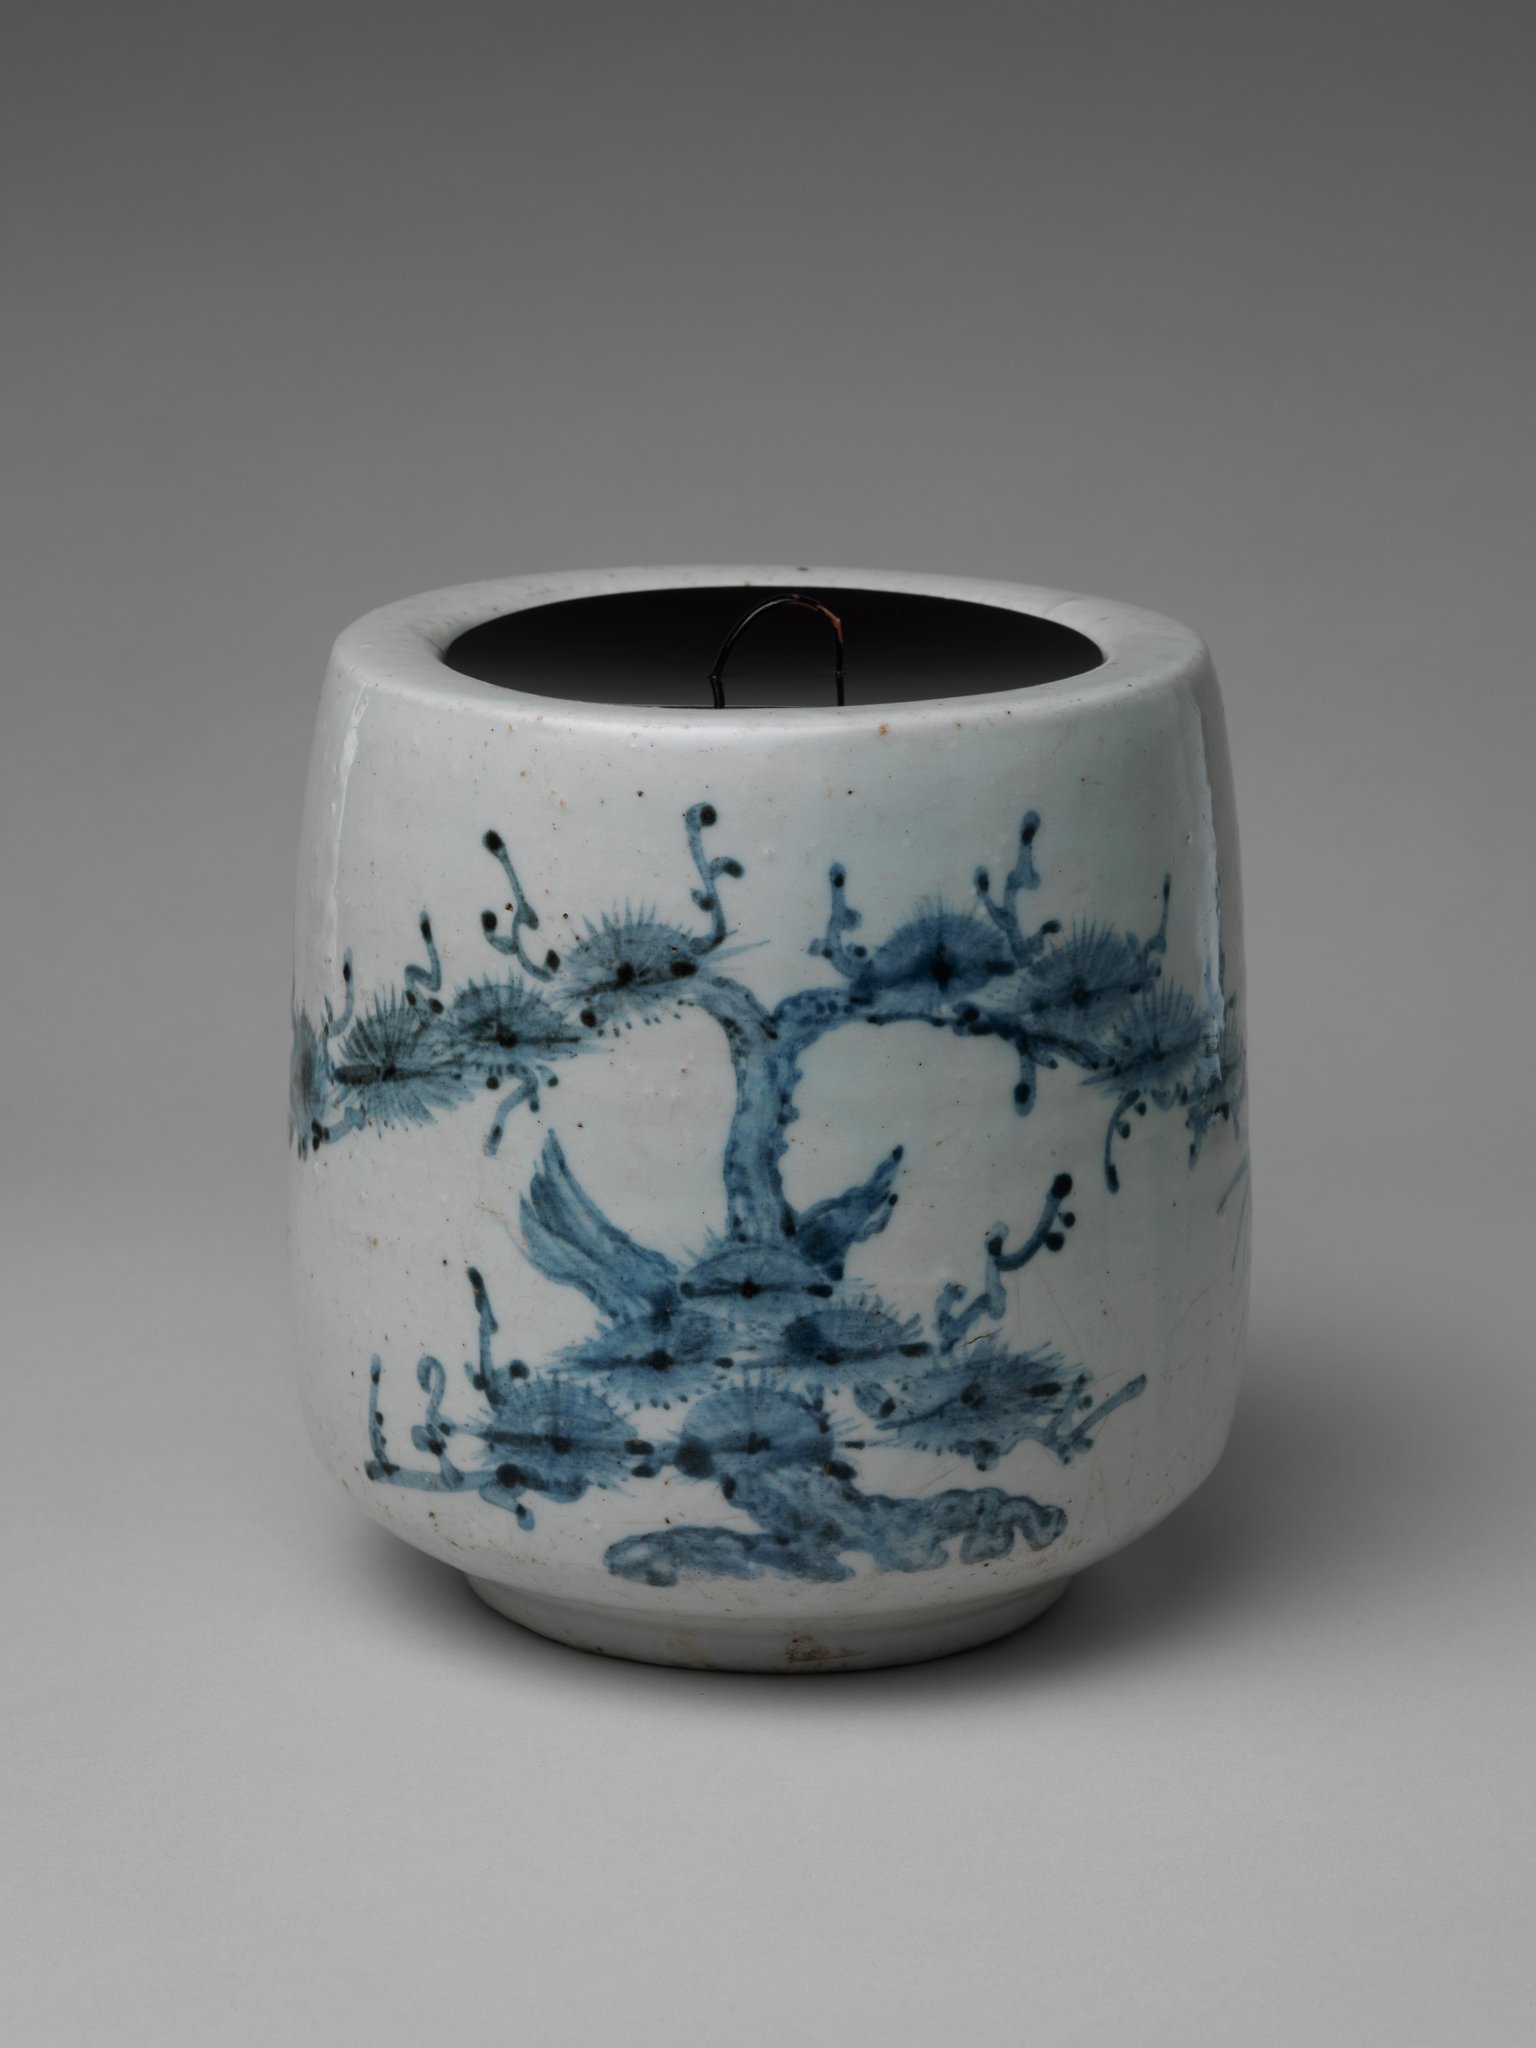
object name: water jar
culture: japanese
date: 1624-1643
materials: cobalt, porcelain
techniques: underglaze